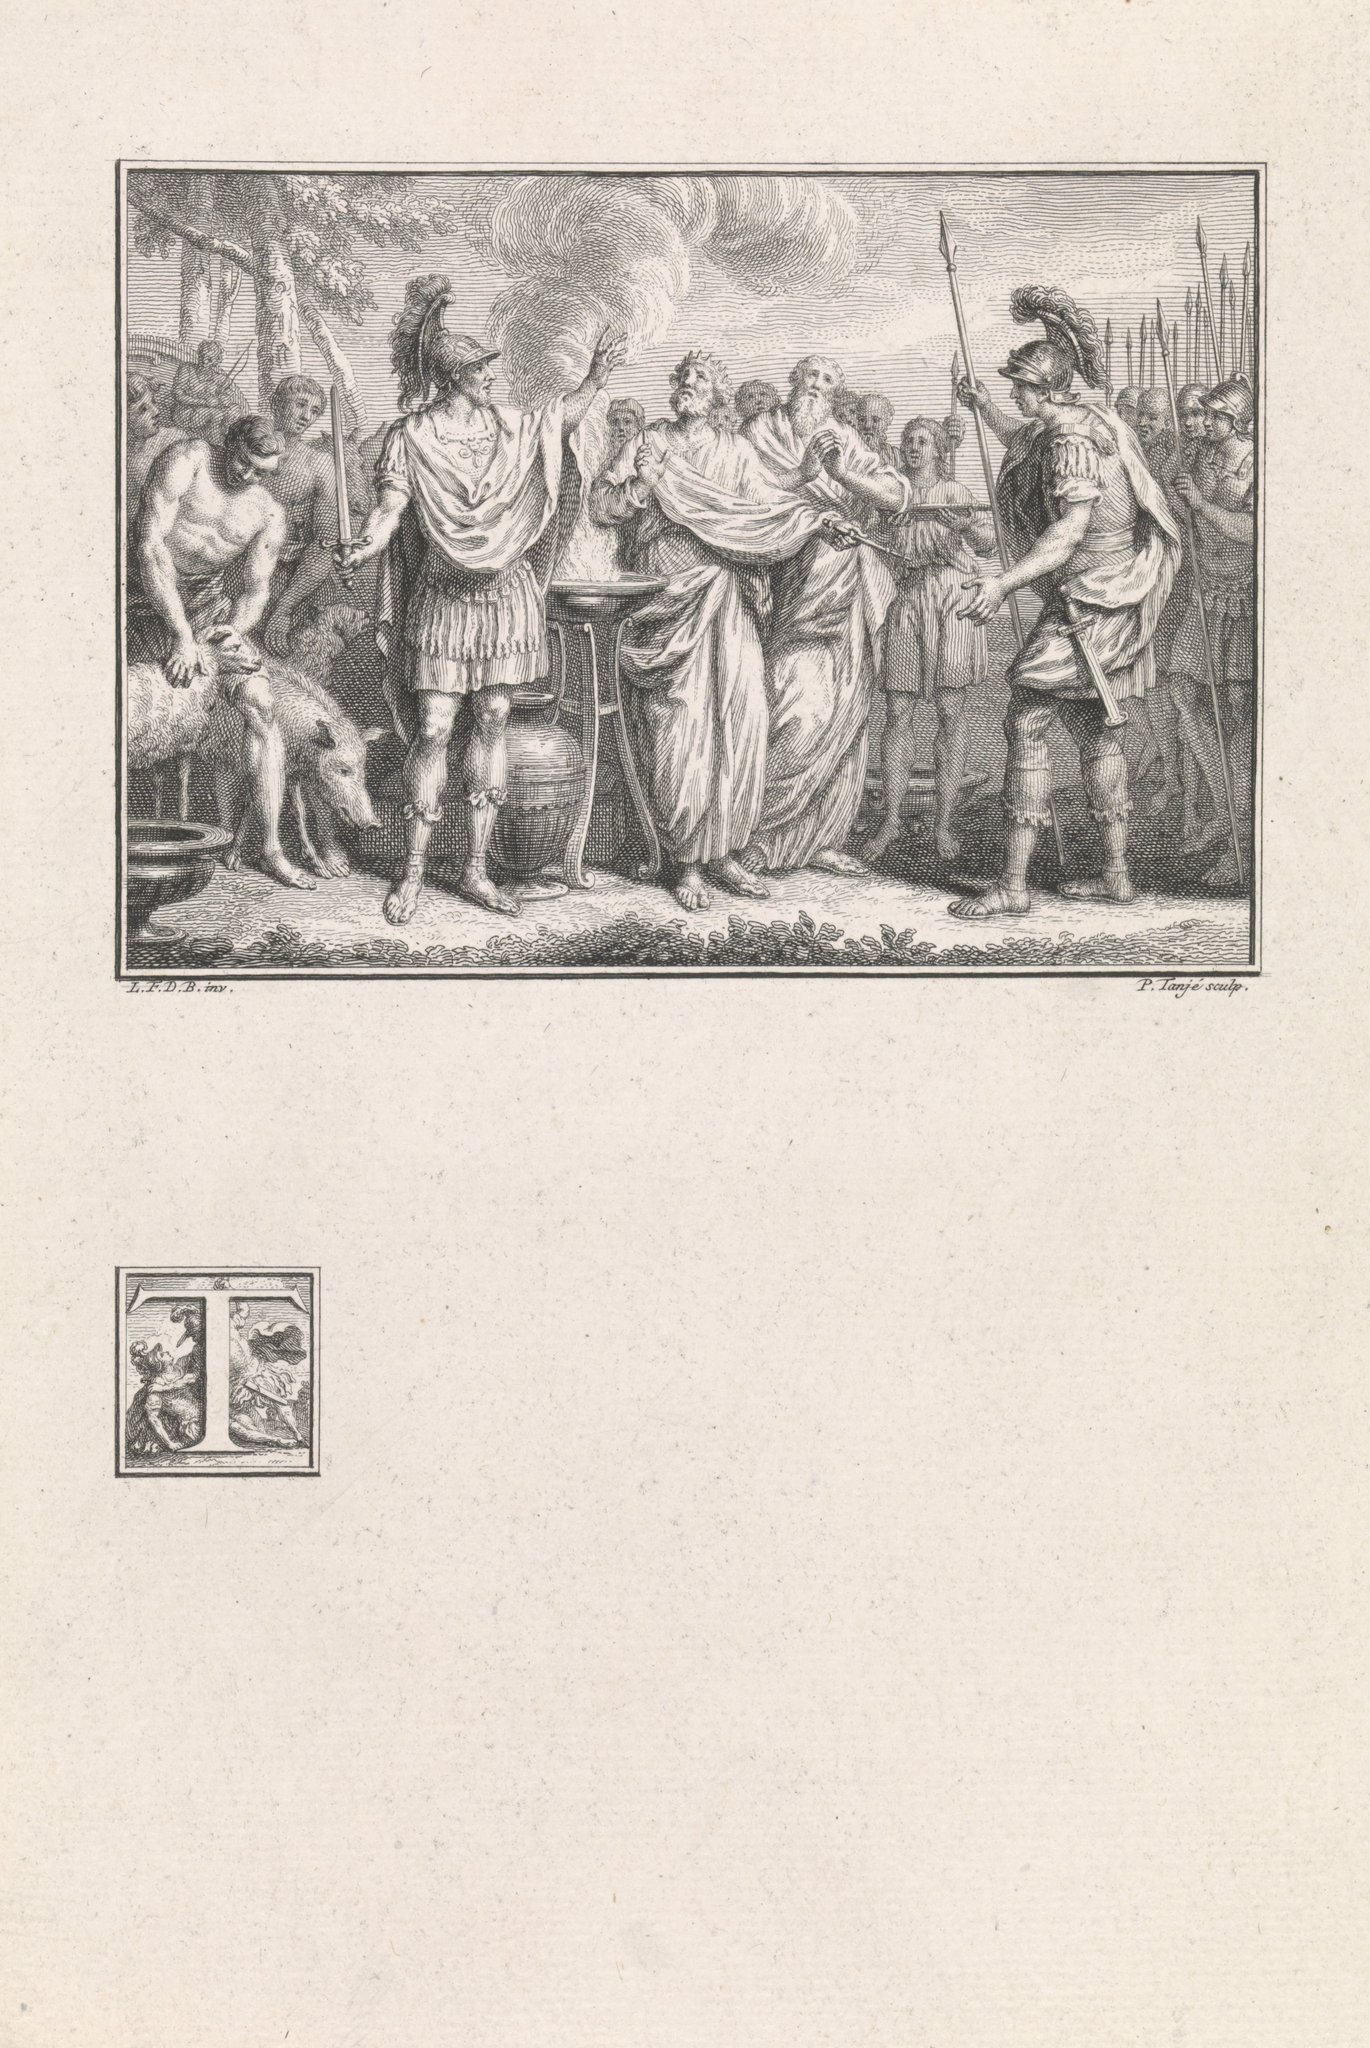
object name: book illustration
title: Turnus en Aeneas bereiden zich voor op het tweegevecht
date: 1746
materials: paper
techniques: engraving, etching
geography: amsterdam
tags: battle of latium (ii): respite and battle again (virgil, aeneid xi); the last deeds of turnus (virgil, aeneid xii)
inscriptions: collector's mark: Lugt 240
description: Turnus en Aeneas bereiden zich voor op het tweegevecht. Tussen hen in staat koning Latinus naast een offerschaal. Illustratie en initiaal T bij het twaalfde deel van de Aeneis van Vergilius.